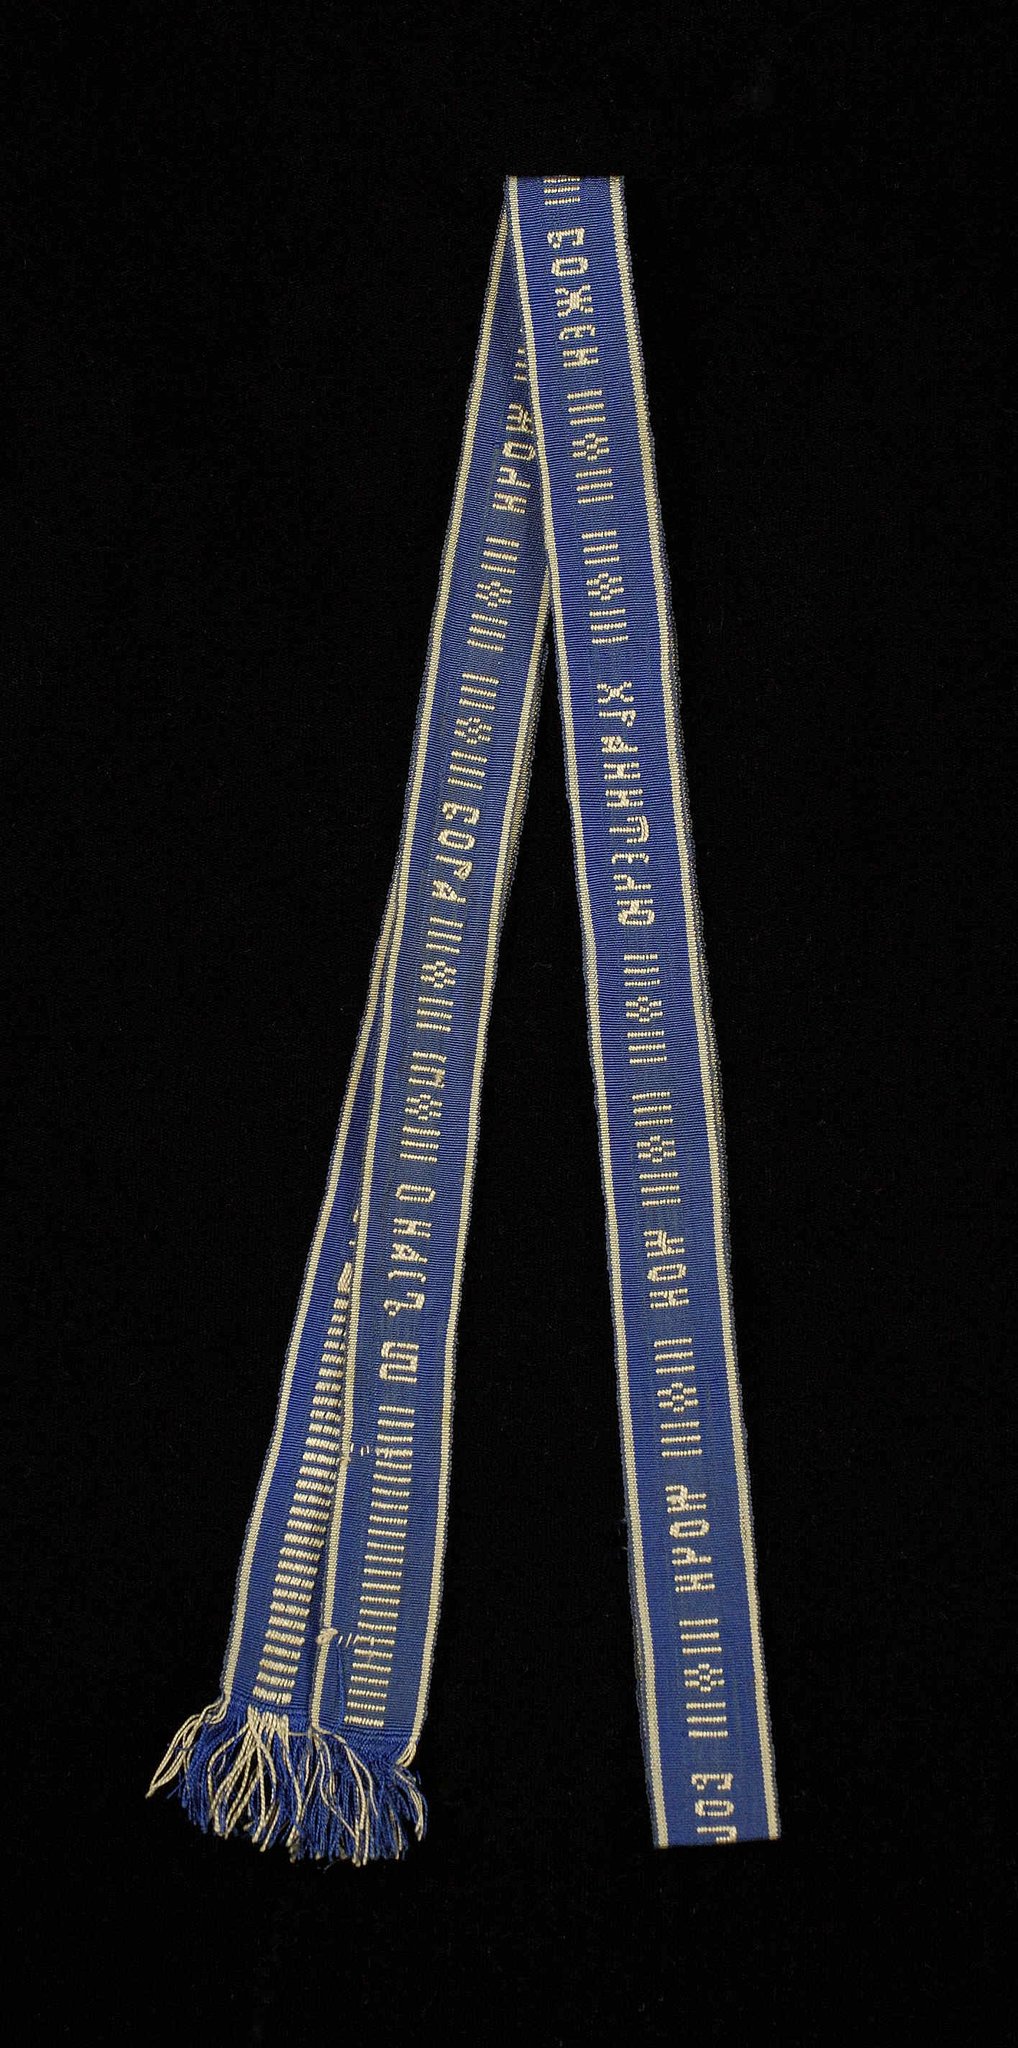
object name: sash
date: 1801-1900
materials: silk